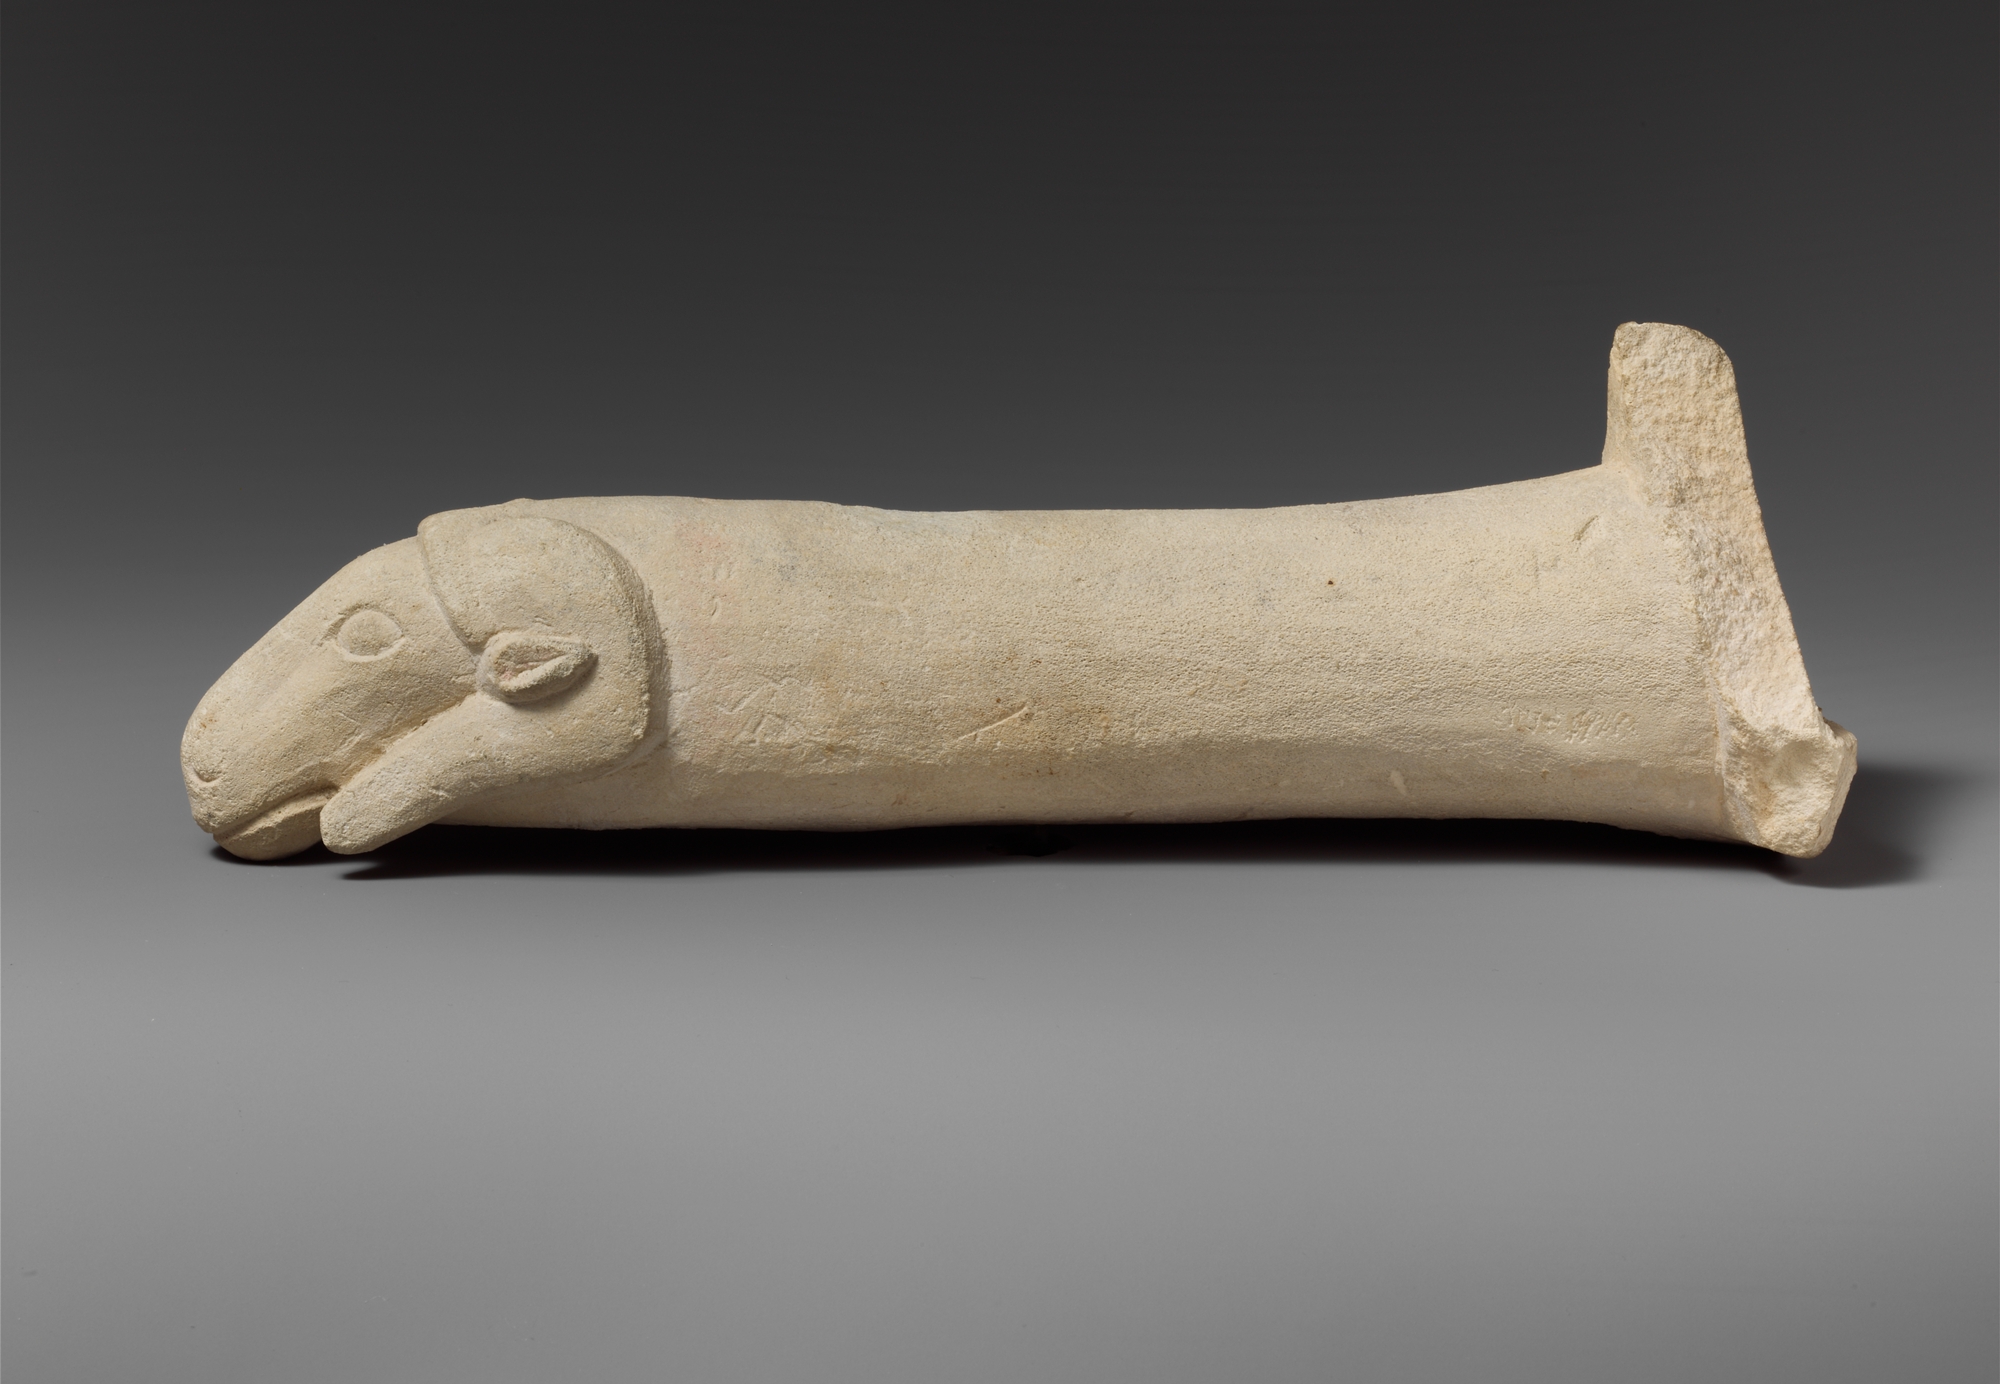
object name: handle of a ladle or fire shovel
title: Limestone handle of a patera or a fire shovel ending in a ram’s head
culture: cypriot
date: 500-401 BCE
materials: limestone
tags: rams